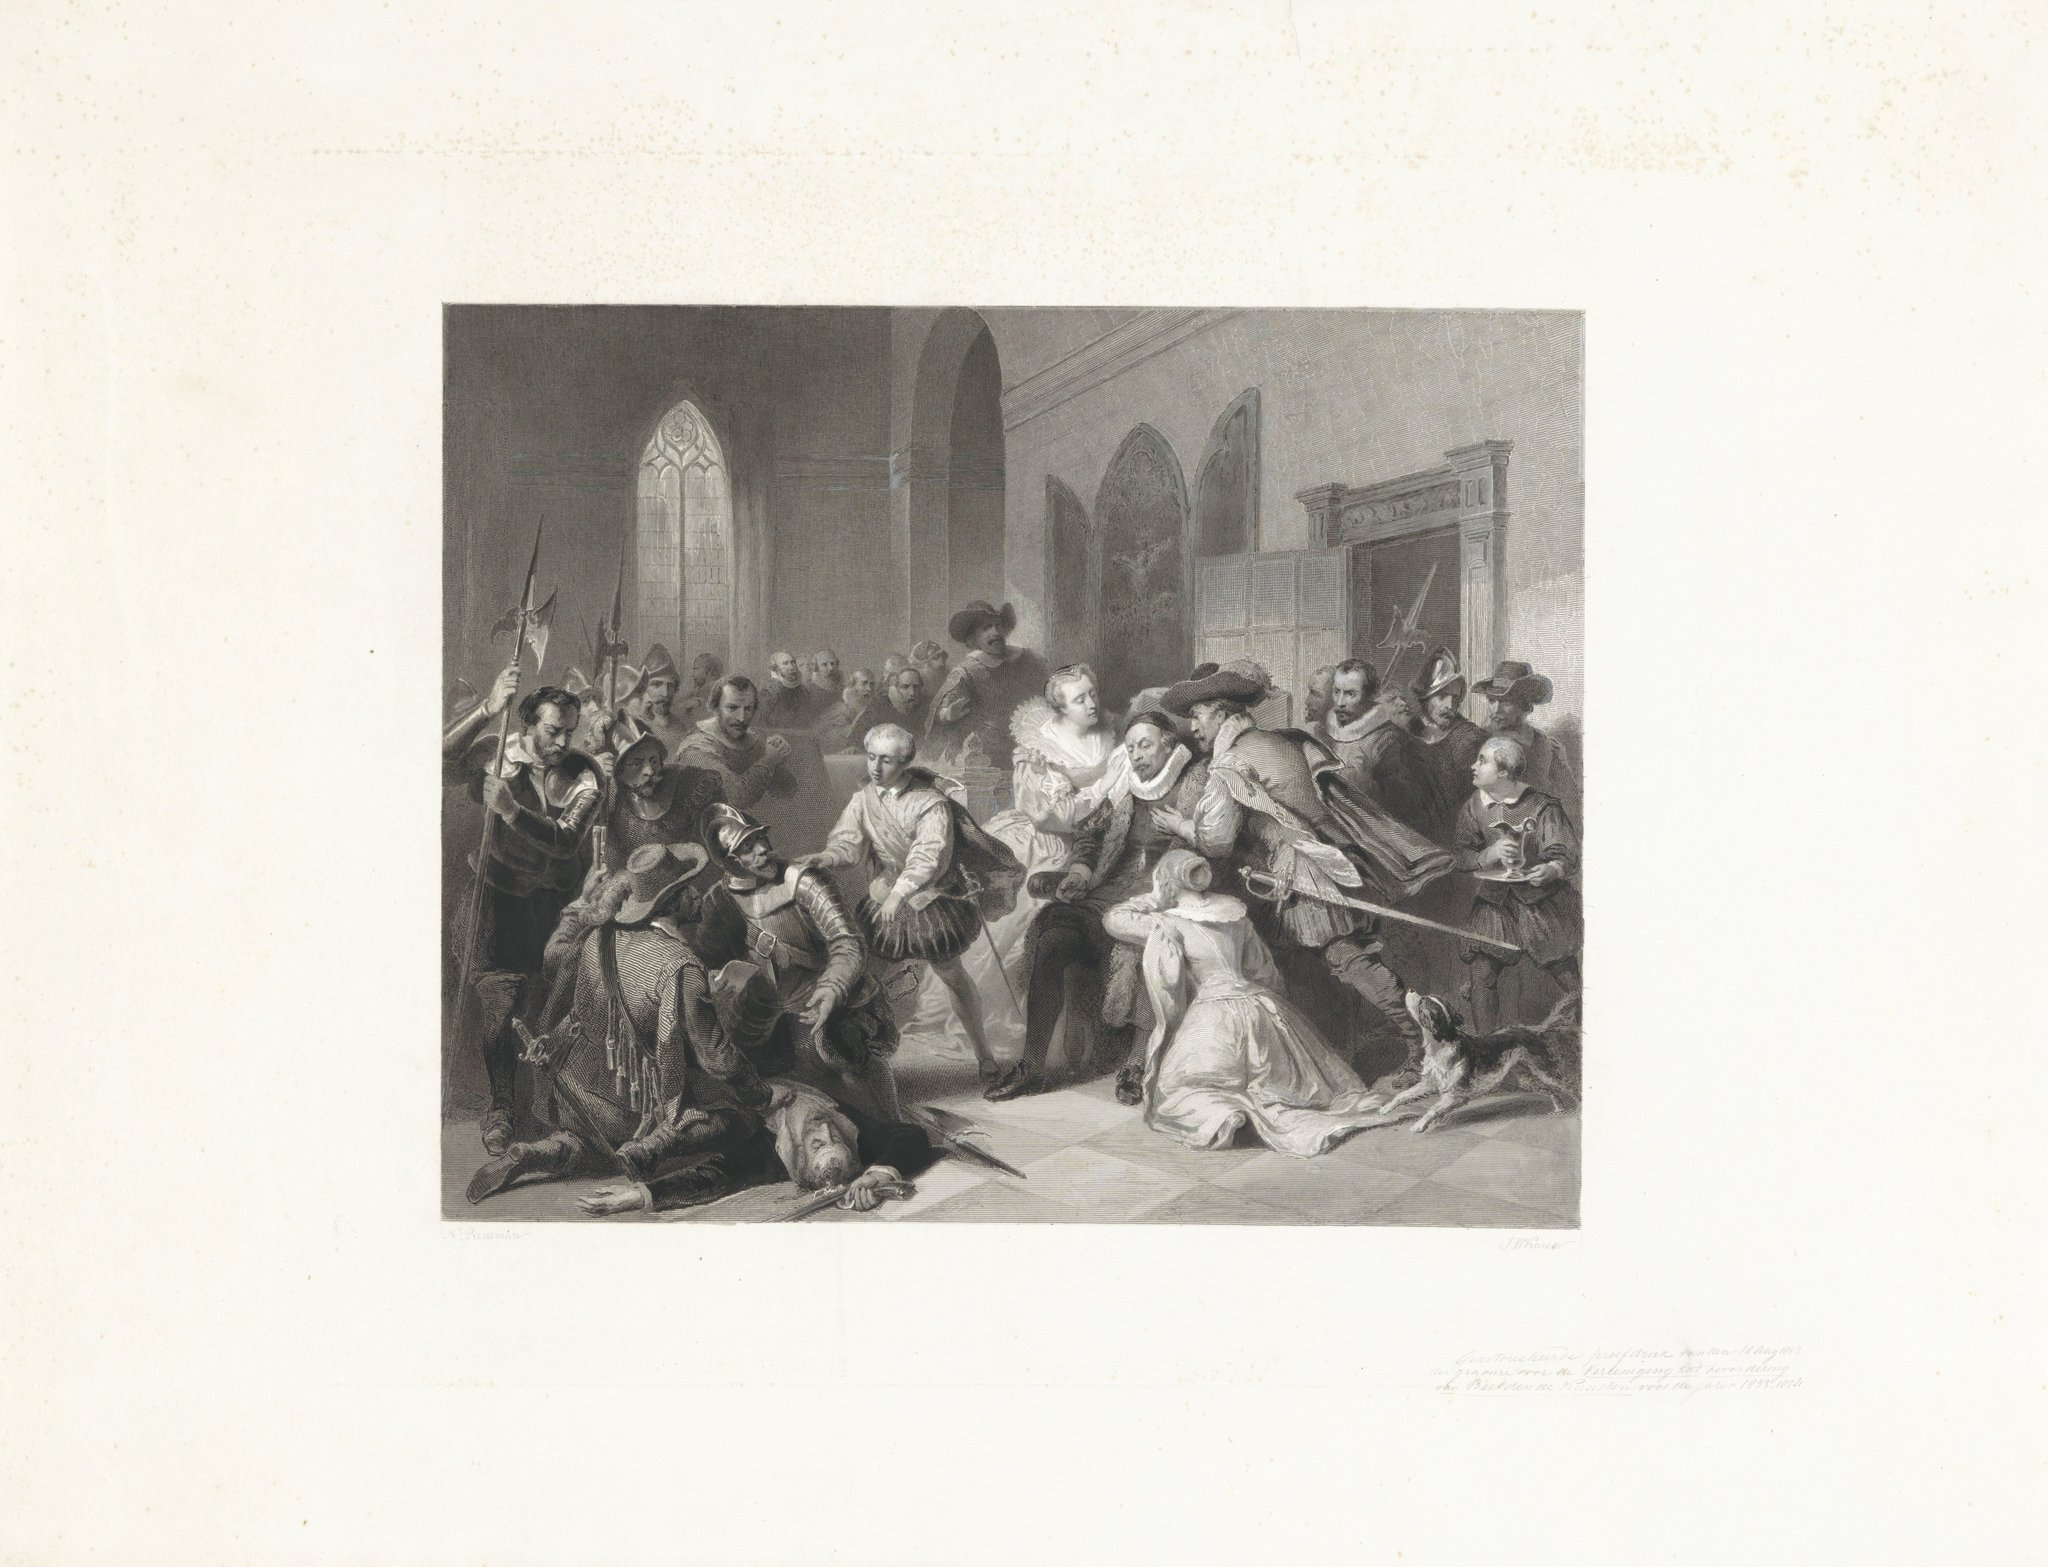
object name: print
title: Aanslag van Jean de Jauregui op prins Willem I, 18 maart 1582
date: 1853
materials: paper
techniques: brush, engraving, etching, roulette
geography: amsterdam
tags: antwerp, charlotte of bourbon, delft, william i (prince of orange), the hague, maurice (prince of orange)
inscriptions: collector's mark: Lugt 2228, inscription: ‘Geretoucheerde proefdruk van den 12 aug 1853 / der gravure voor de Vereniging tot bevordering / van Beeldende Kunsten voor de jaren 1853-1854’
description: Aanslag van Jean de Jauregui op prins Willem I, 18 maart 1582 te Antwerpen. Interieur met de prins die gewond in een stoel zit, met familie en anderen om zich heen. Links op de vloer ligt het lichaam van de gedode Jean de Jauregui. Maurits vraagt de soldaten hem te onderzoeken.